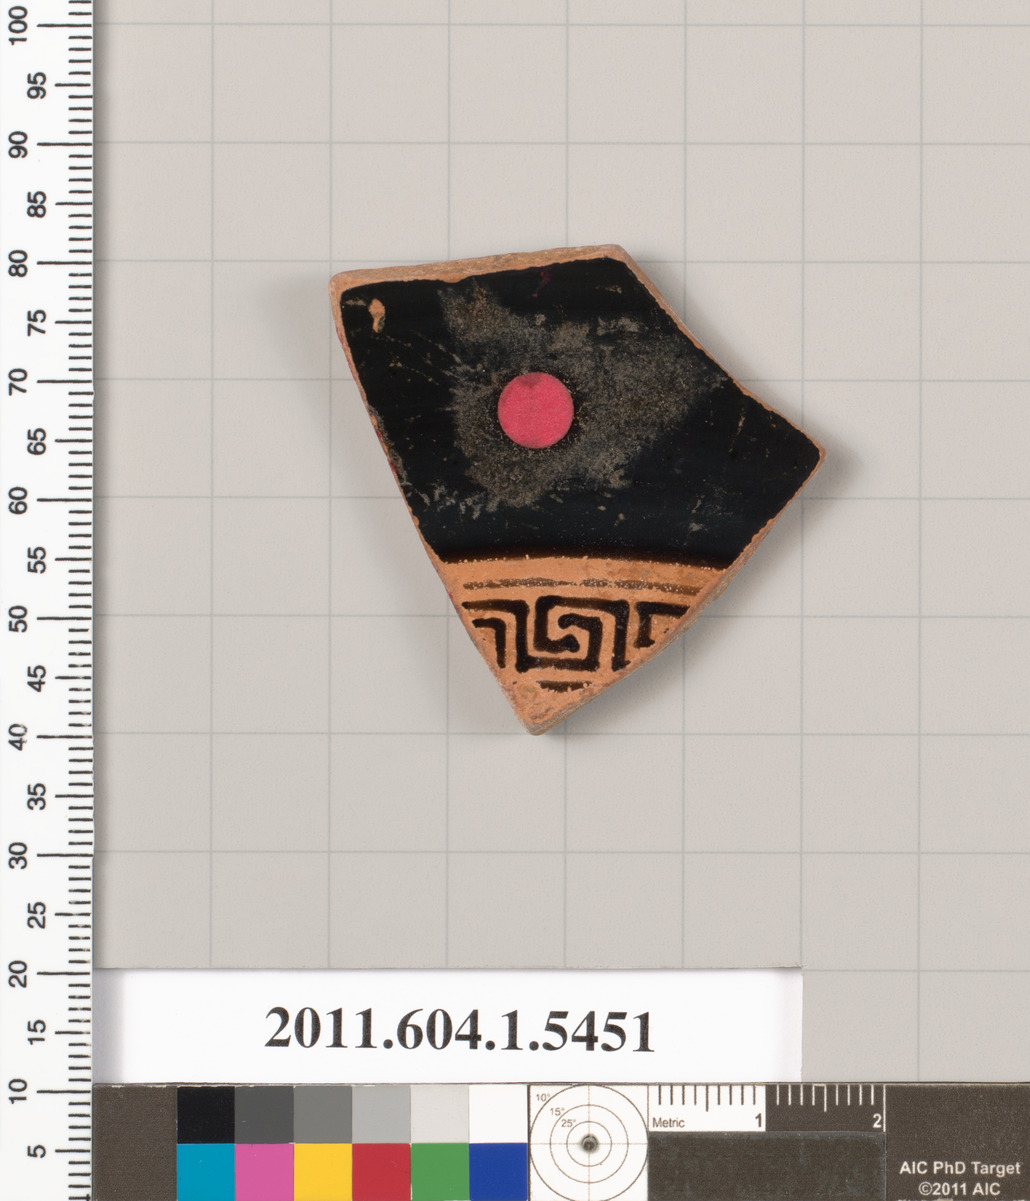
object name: kylix fragment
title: Terracotta fragment of a kylix (drinking cup)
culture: greek, attic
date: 500-480 BCE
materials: terracotta